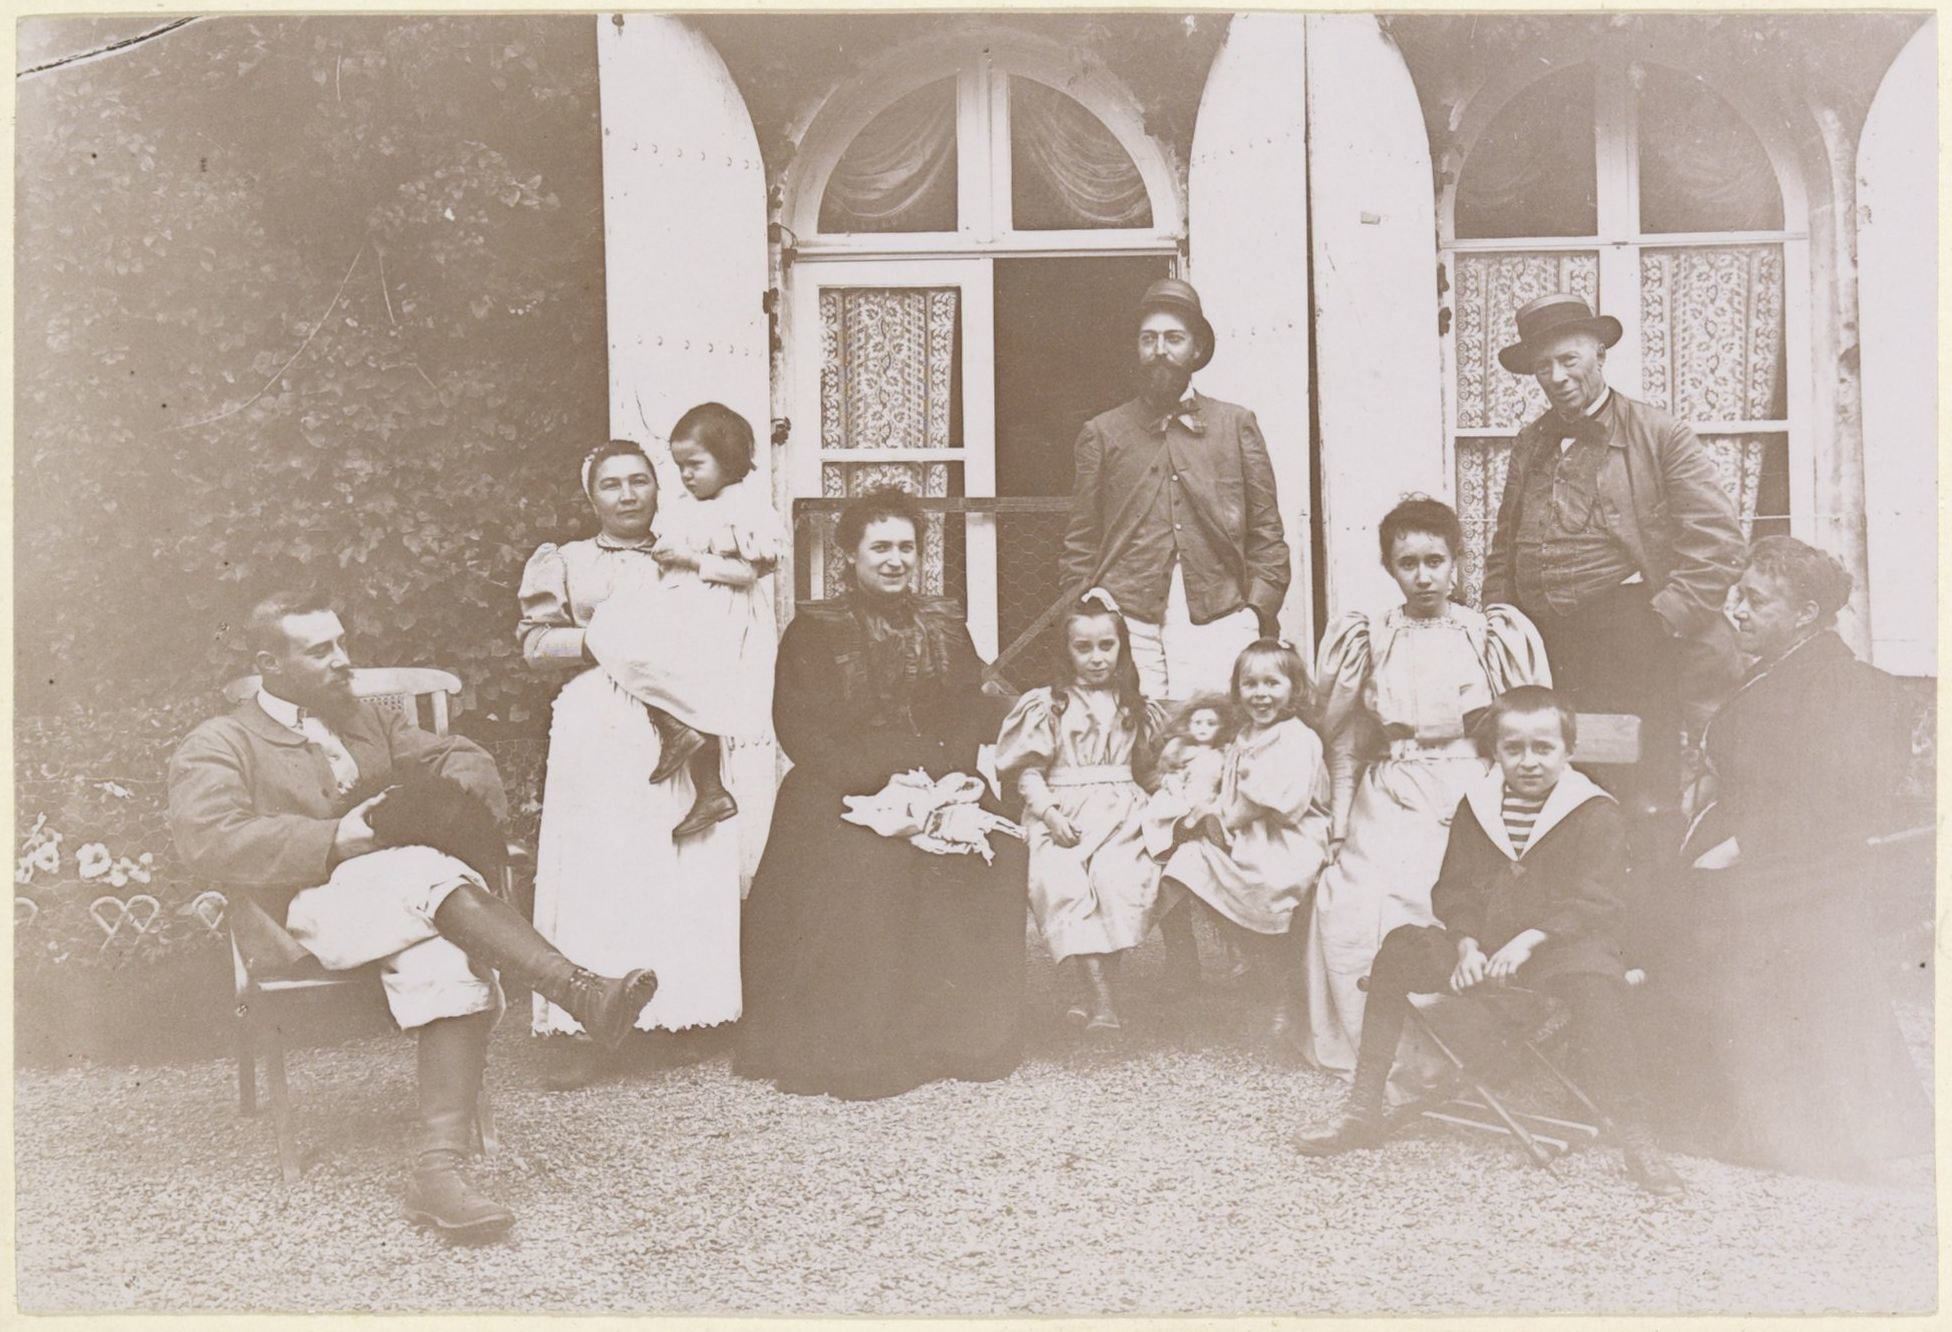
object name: photograph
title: Groepsportret van een Franse familie voor een huis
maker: Anonymous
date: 1900-1910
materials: paper, photographic support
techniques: daylight paper print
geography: france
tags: three generations (family group), france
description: Onderdeel van Fotoalbum van een Franse amateurfotograaf met opnames van een familie, distilleerderij Delizy & Doistau Fils, het leger en bezienswaardigheden in Frankrijk.